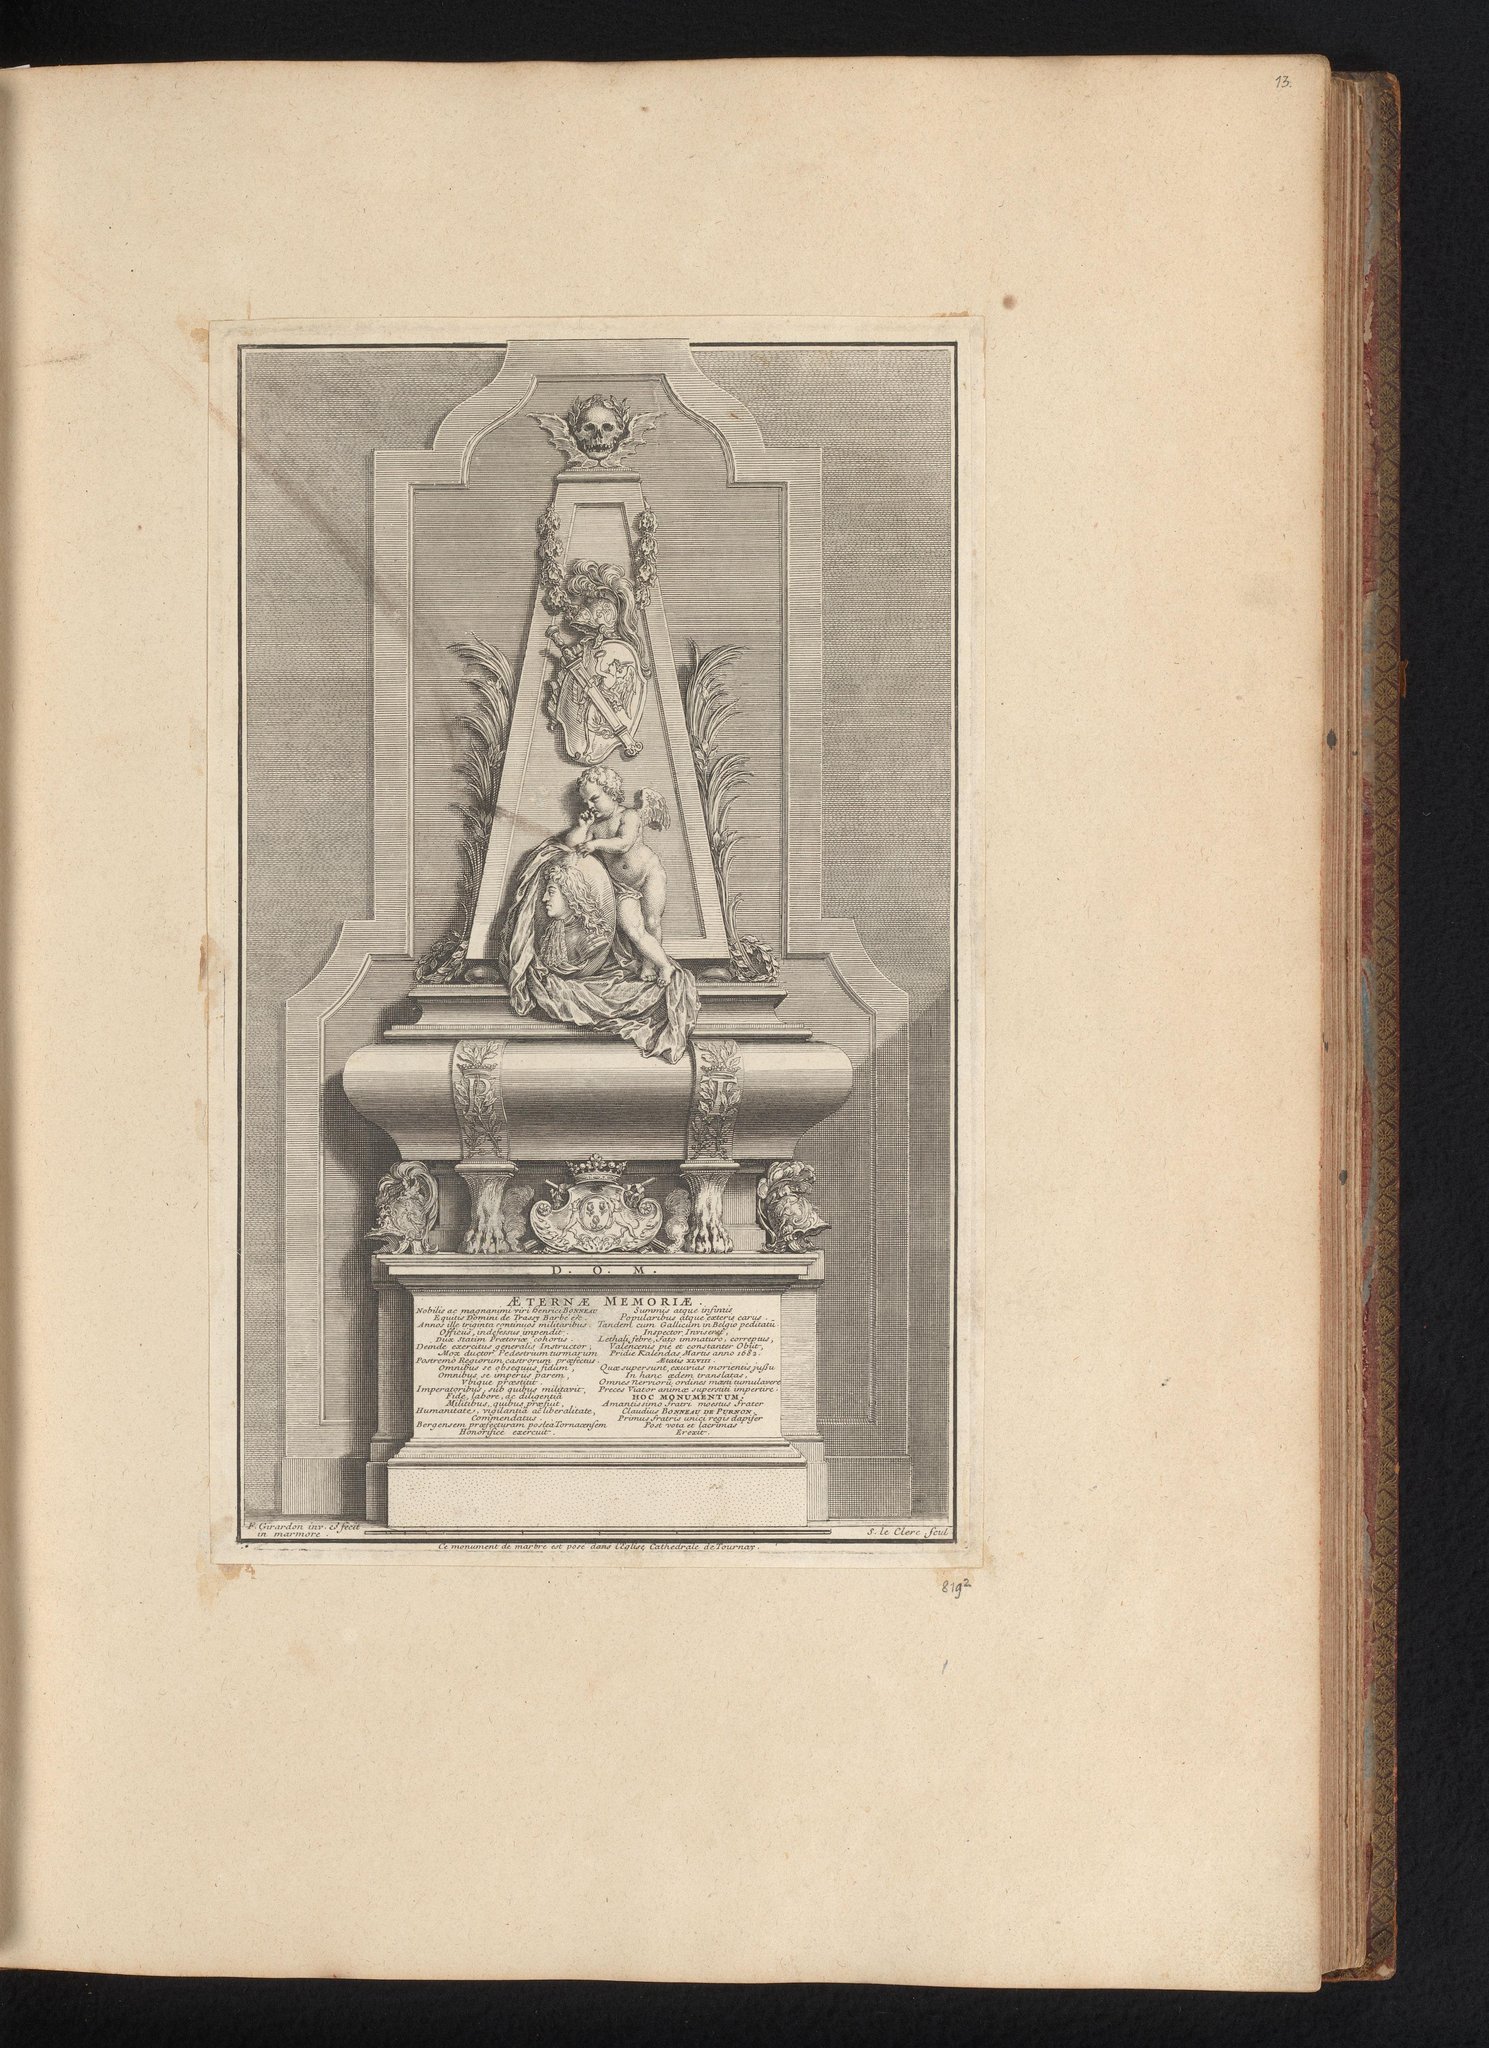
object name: album leaf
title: Grafmonument van Henri Bonneau de Trassy in de kathedraal van Doornik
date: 1685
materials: paper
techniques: engraving, etching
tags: gravestone, tombstone